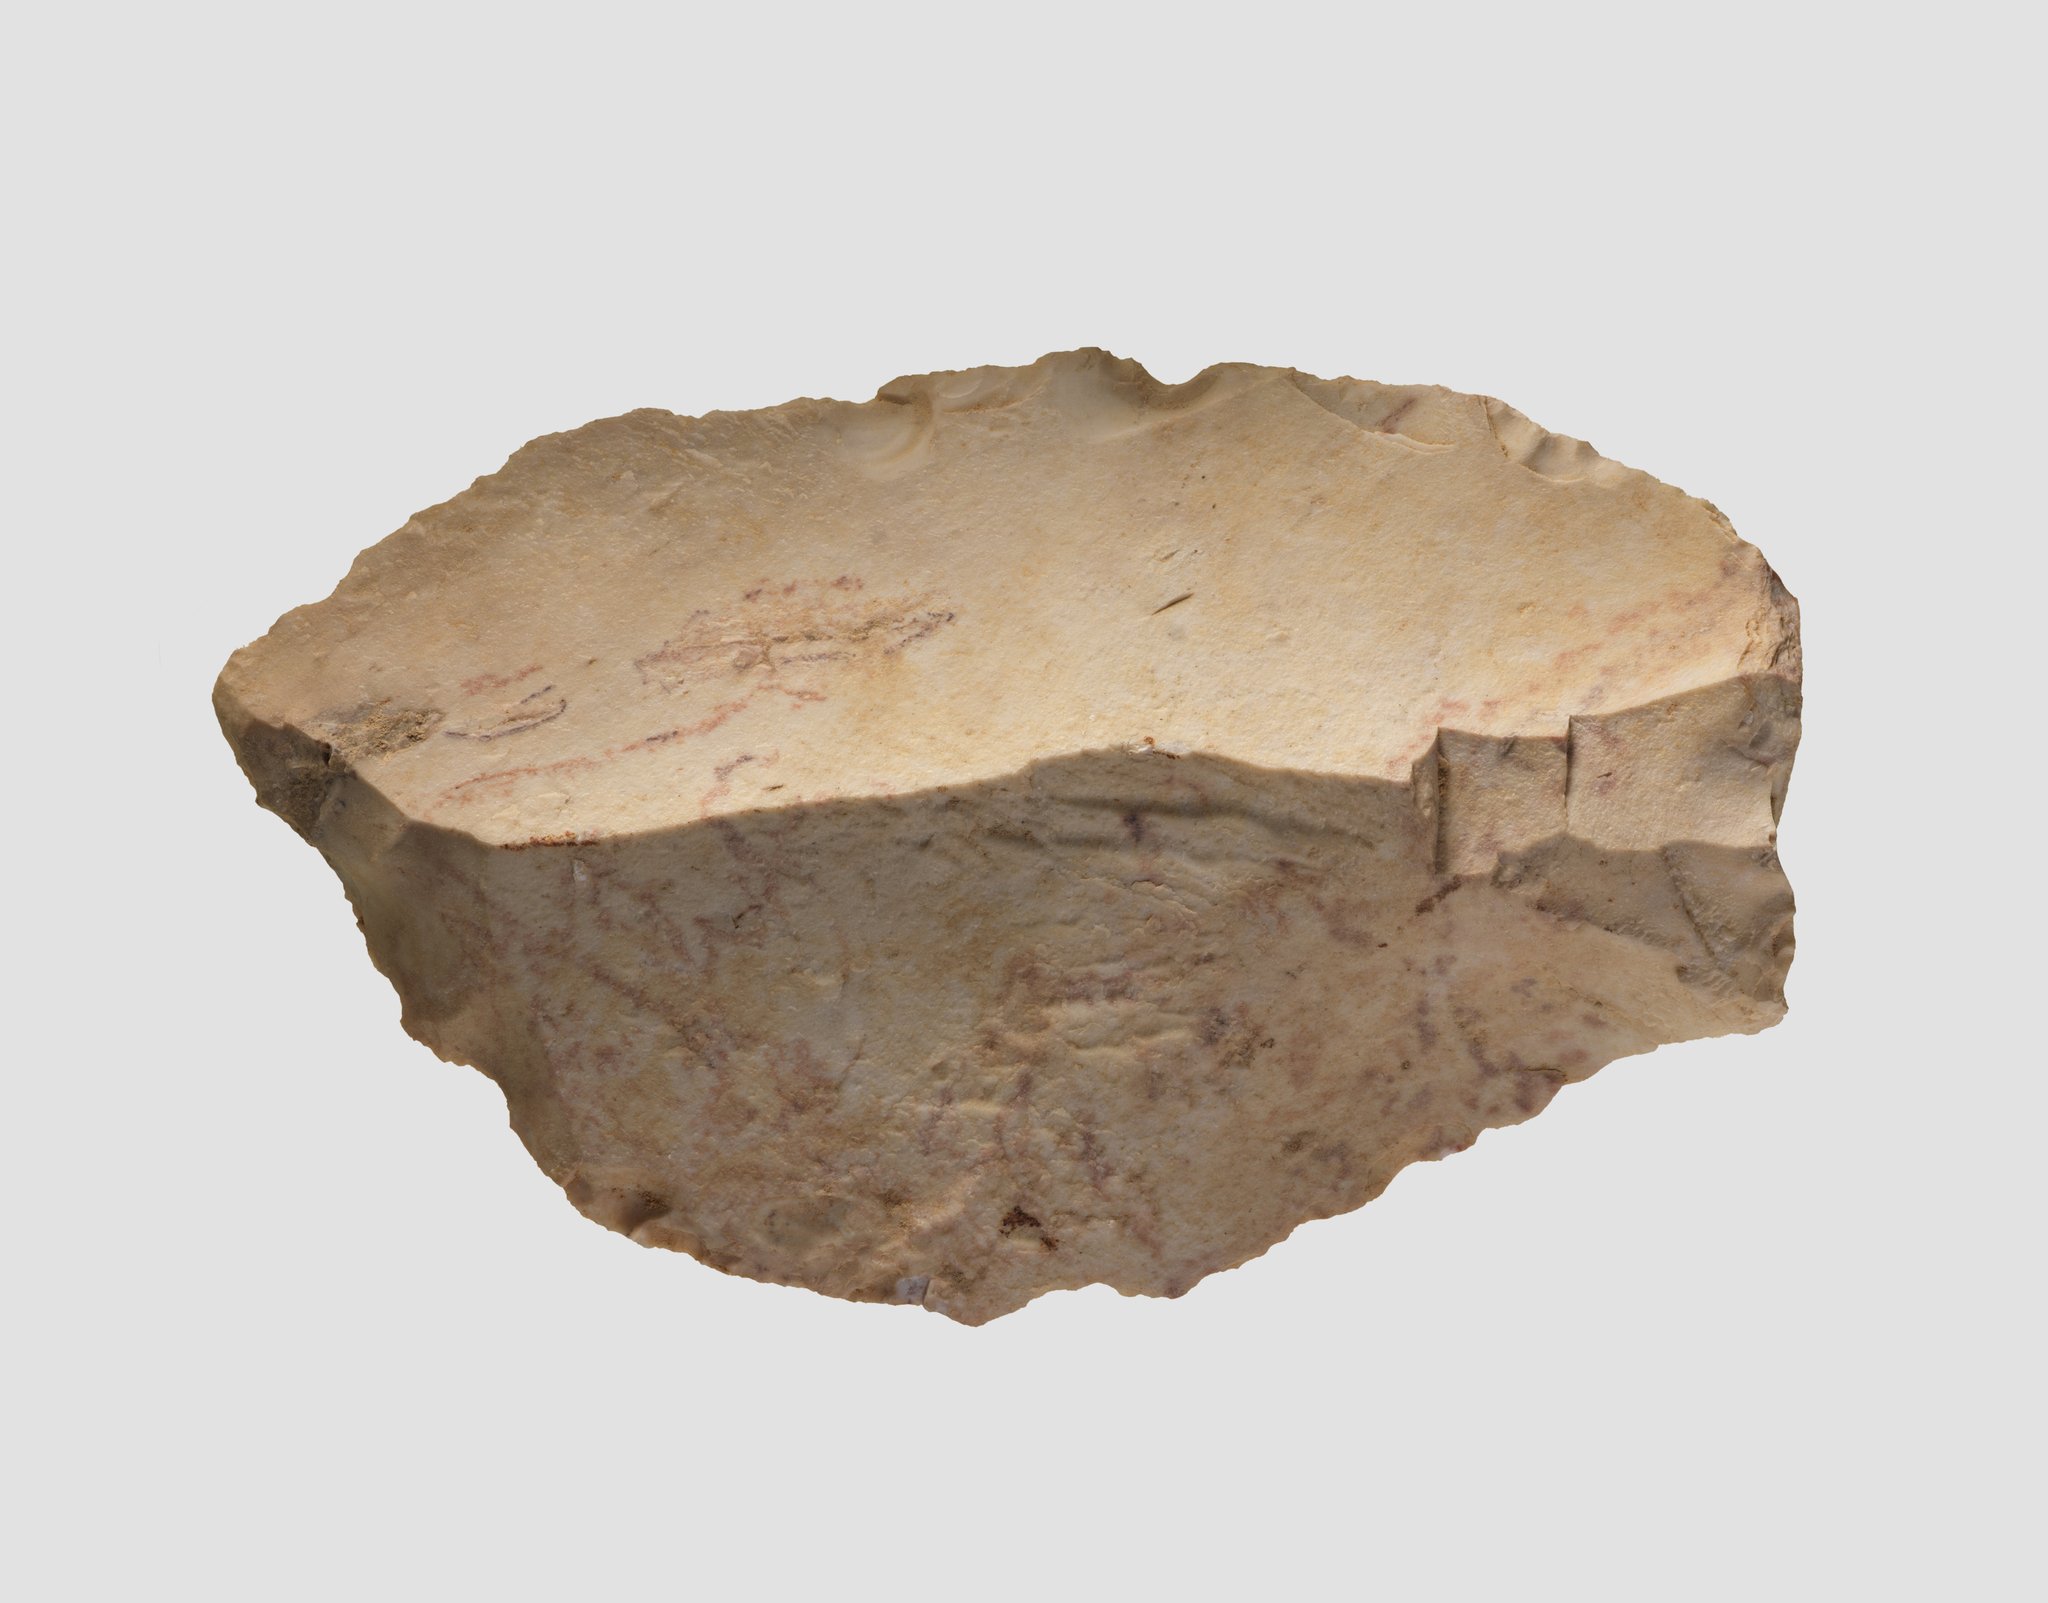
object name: blade or scraper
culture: ghassulian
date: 4600-3600 BCE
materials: stone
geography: levant